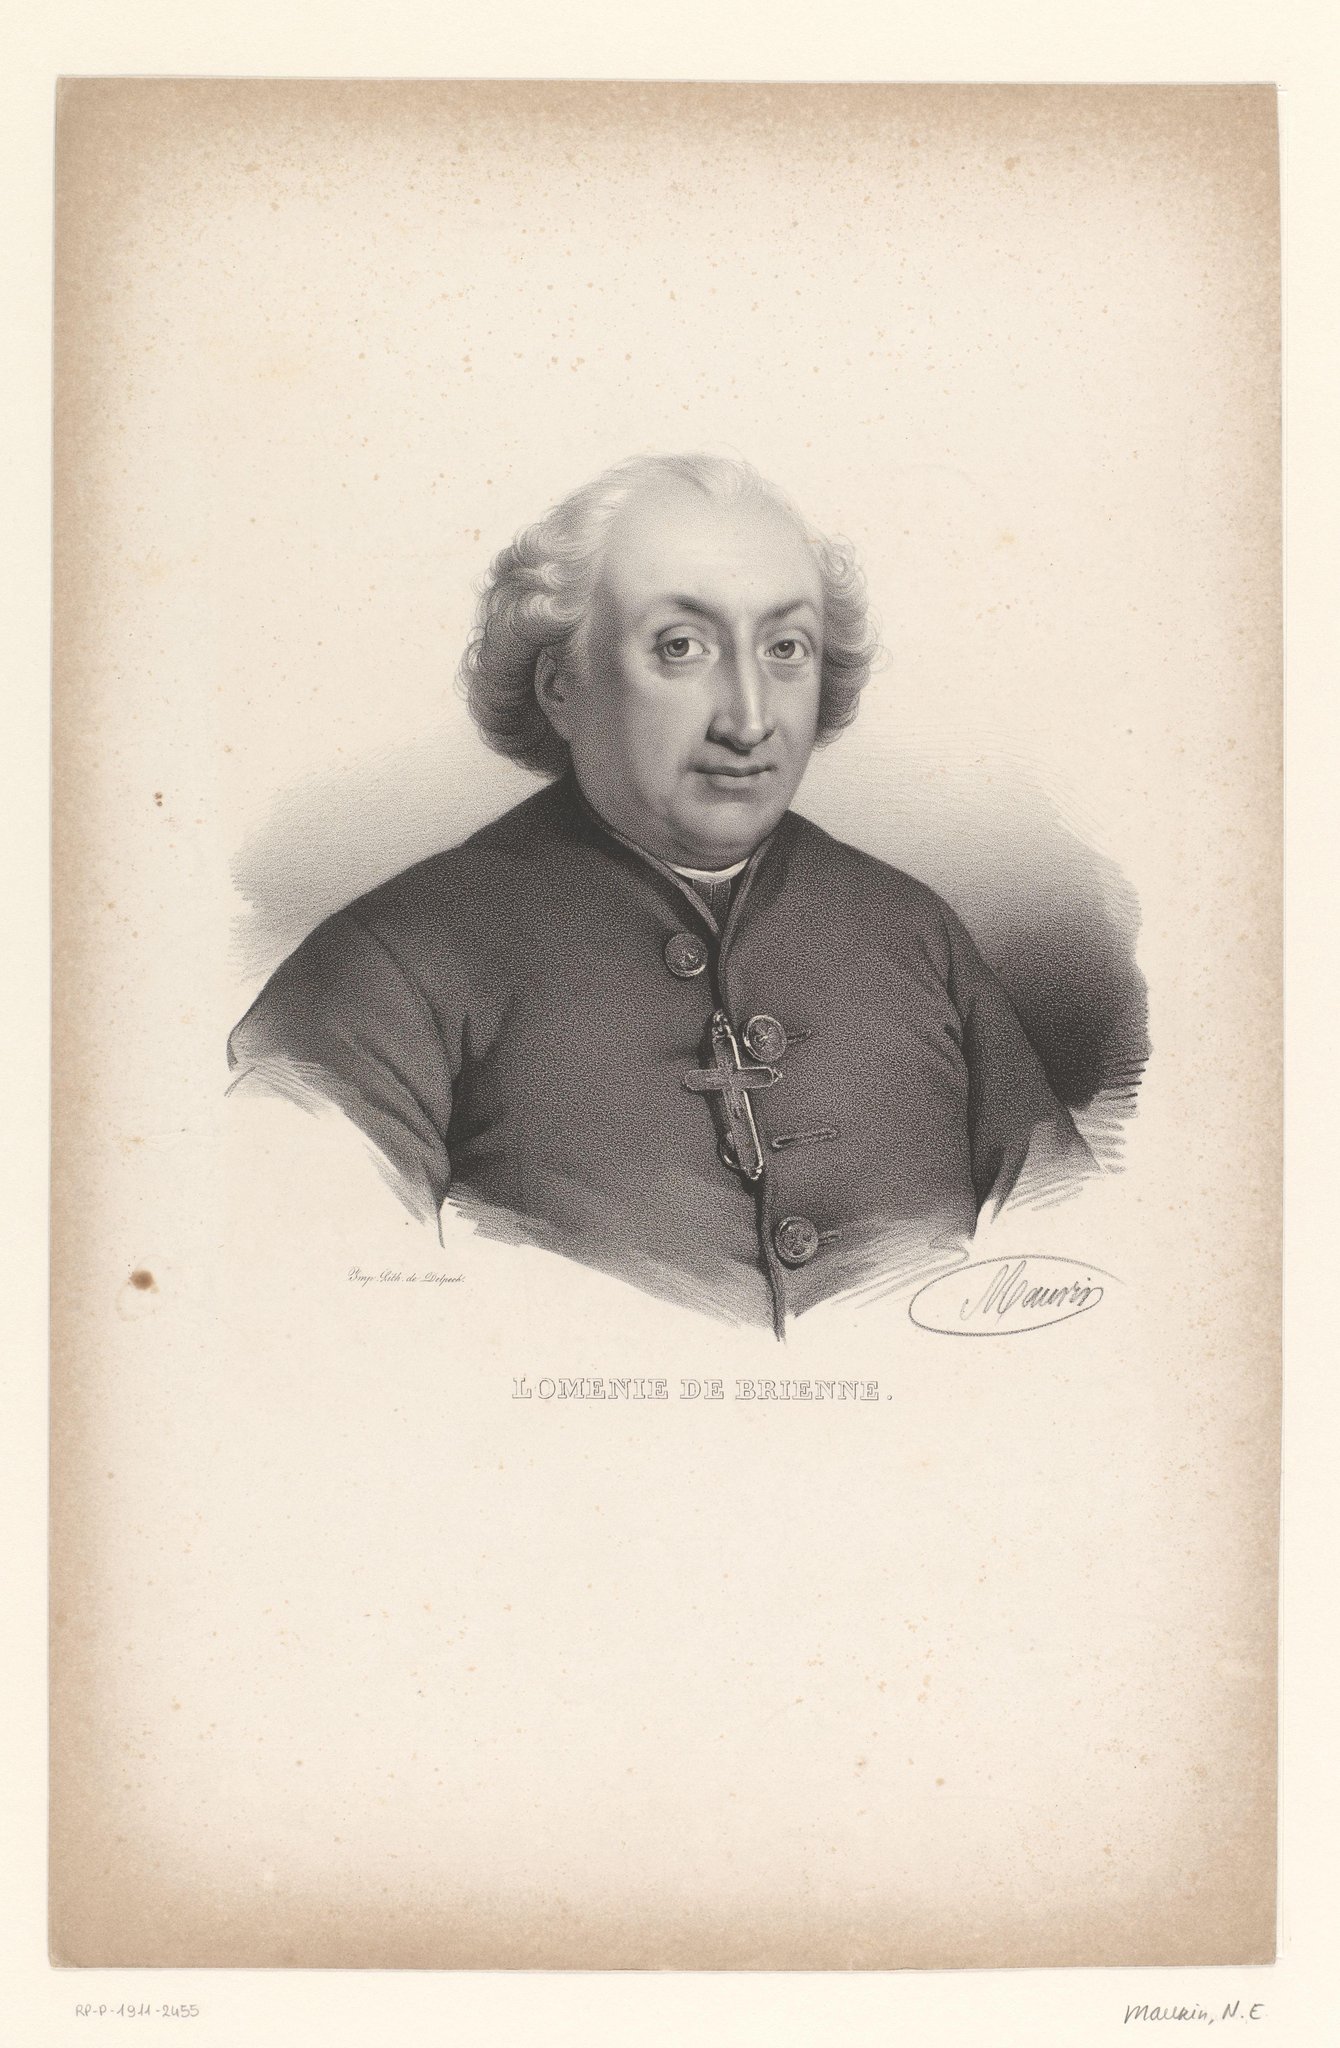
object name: print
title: Lomenie de Brienne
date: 1825-1842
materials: paper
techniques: lithograph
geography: paris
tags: politician, historical persons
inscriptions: collector's mark: Lugt 2228